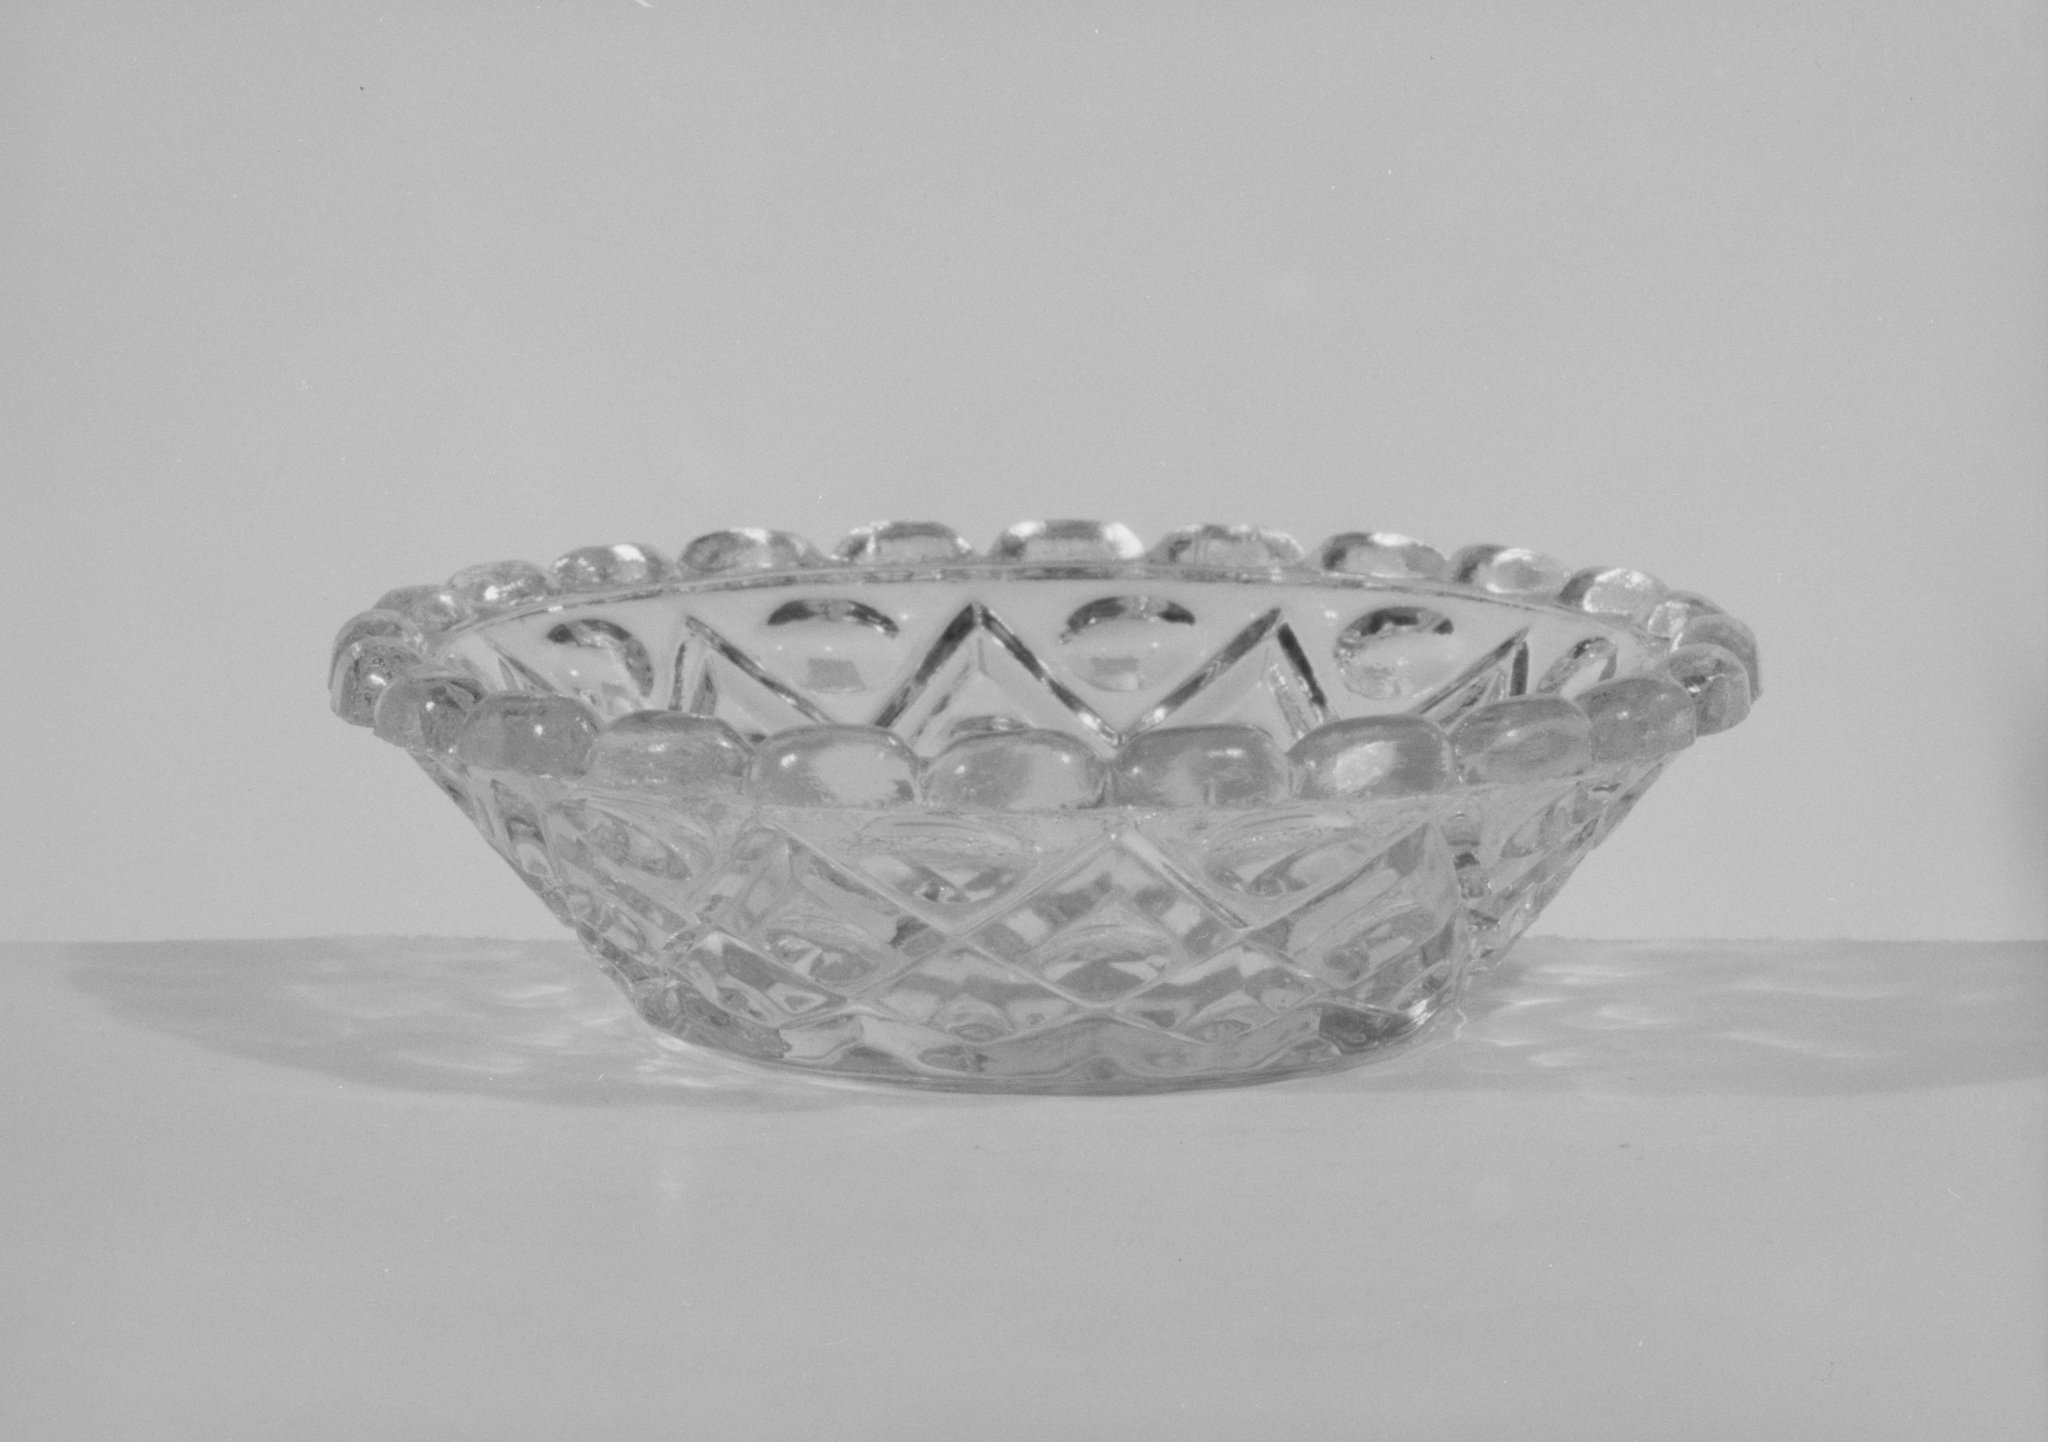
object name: honey dish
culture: american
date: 1850-1860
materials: diamond, glass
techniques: pressed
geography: united states